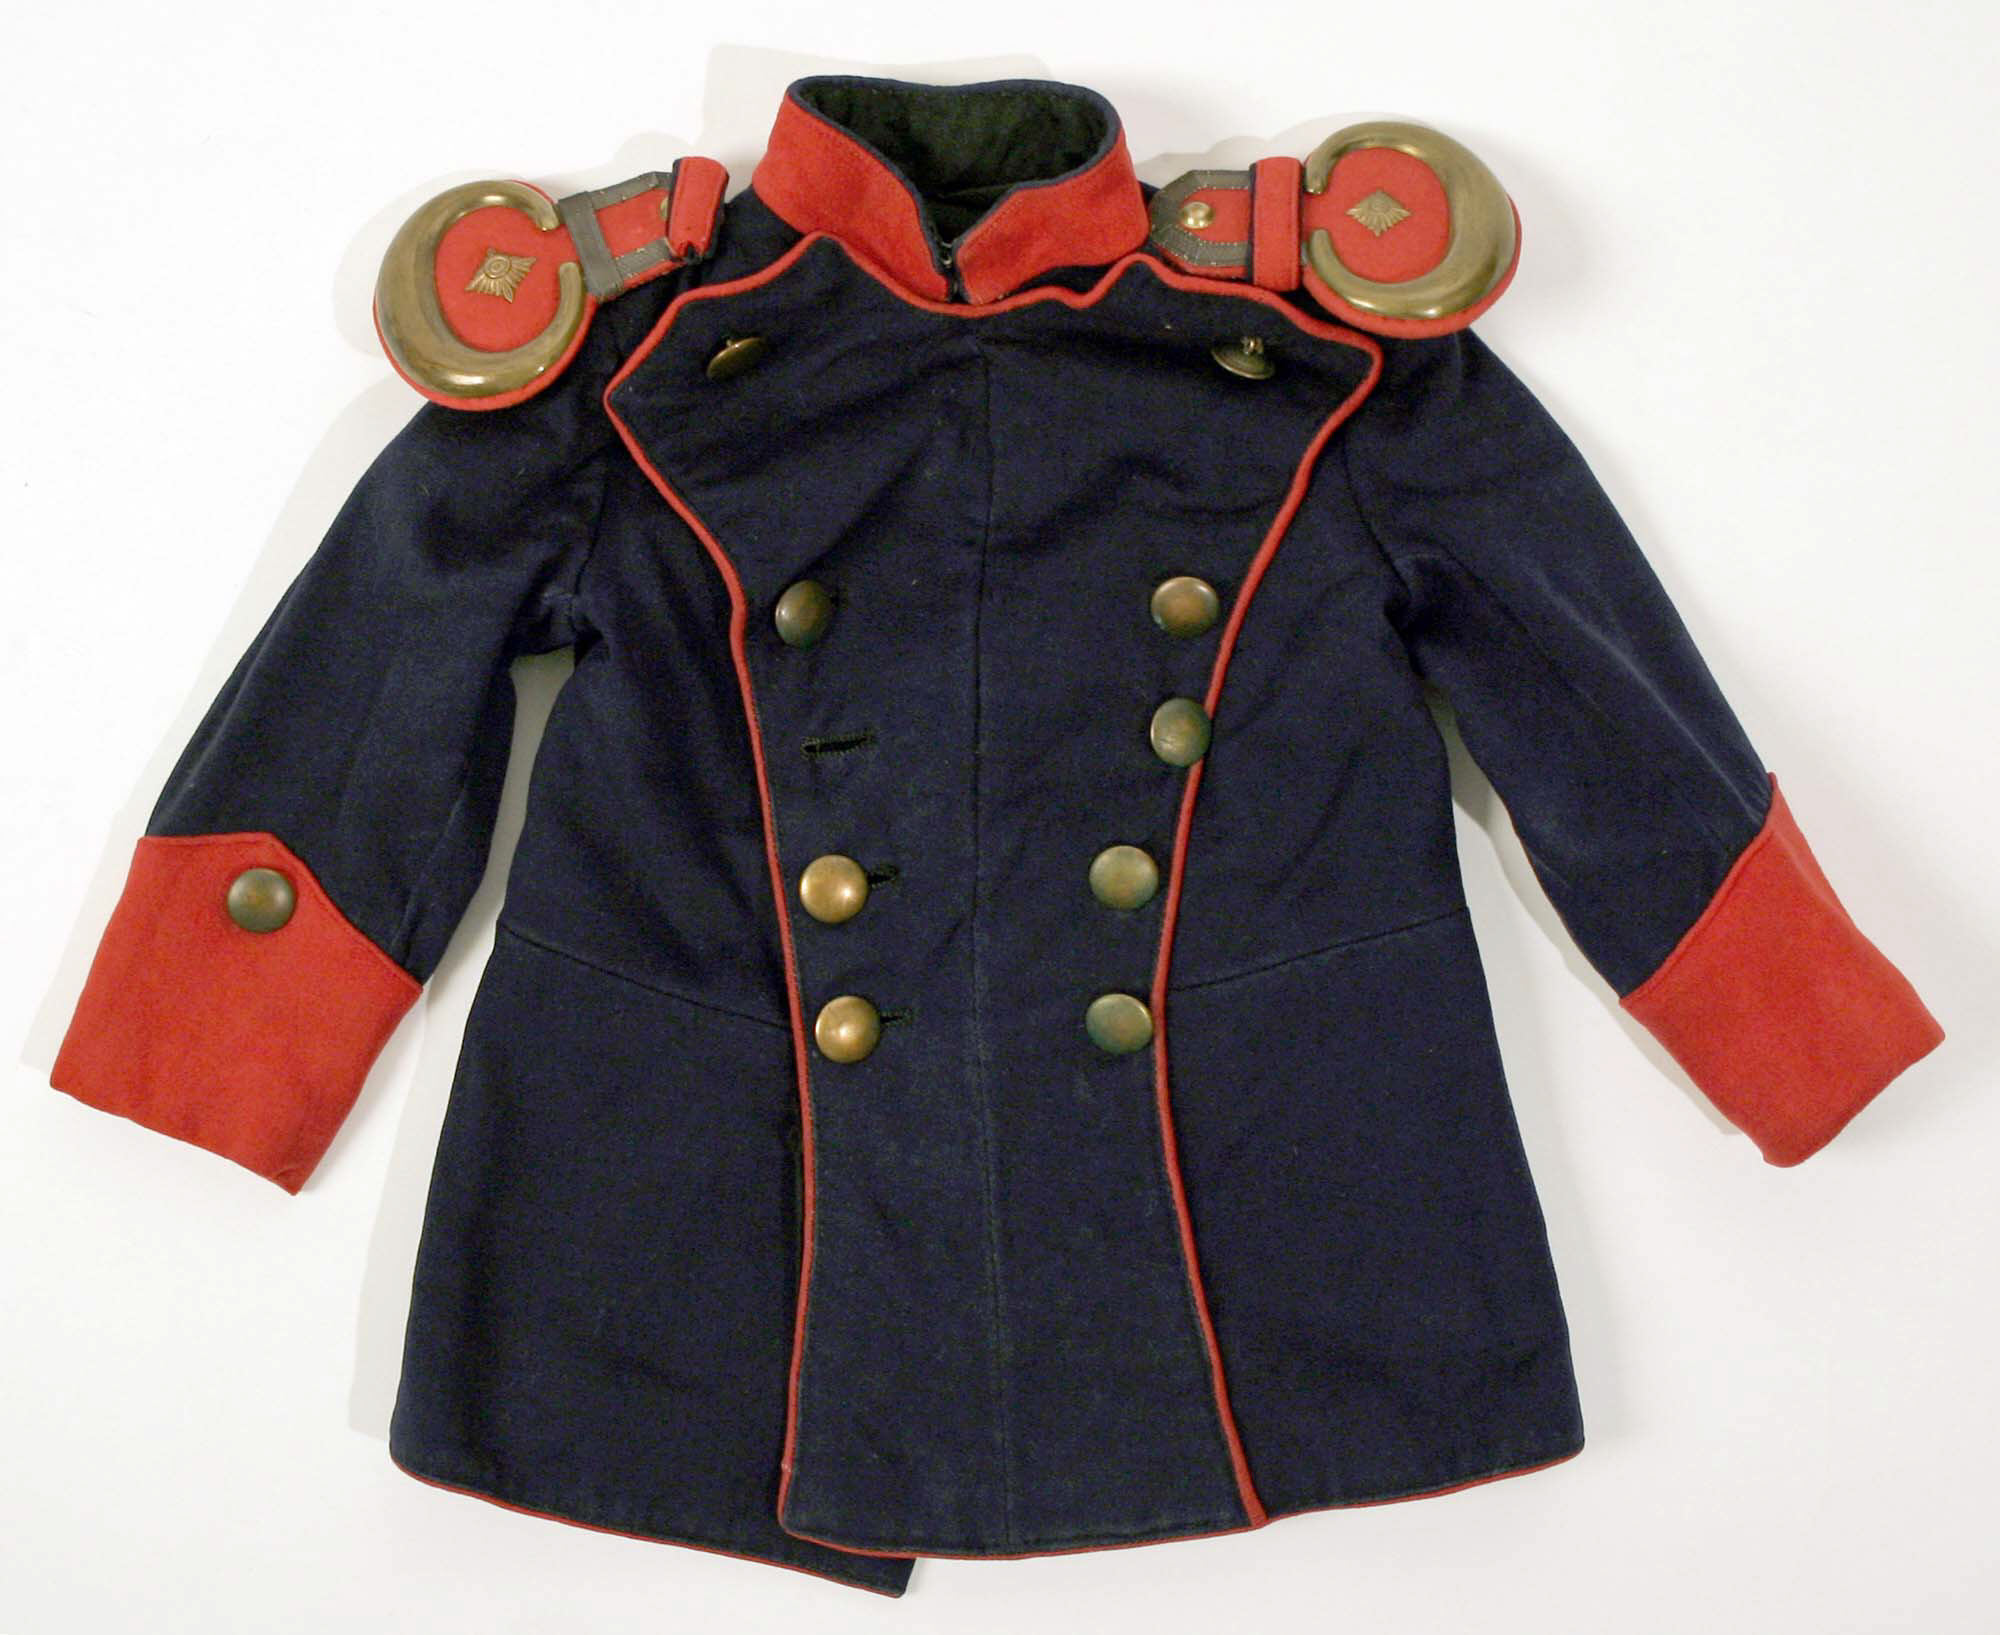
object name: jacket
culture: german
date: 1898-1900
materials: brass, metal, wool